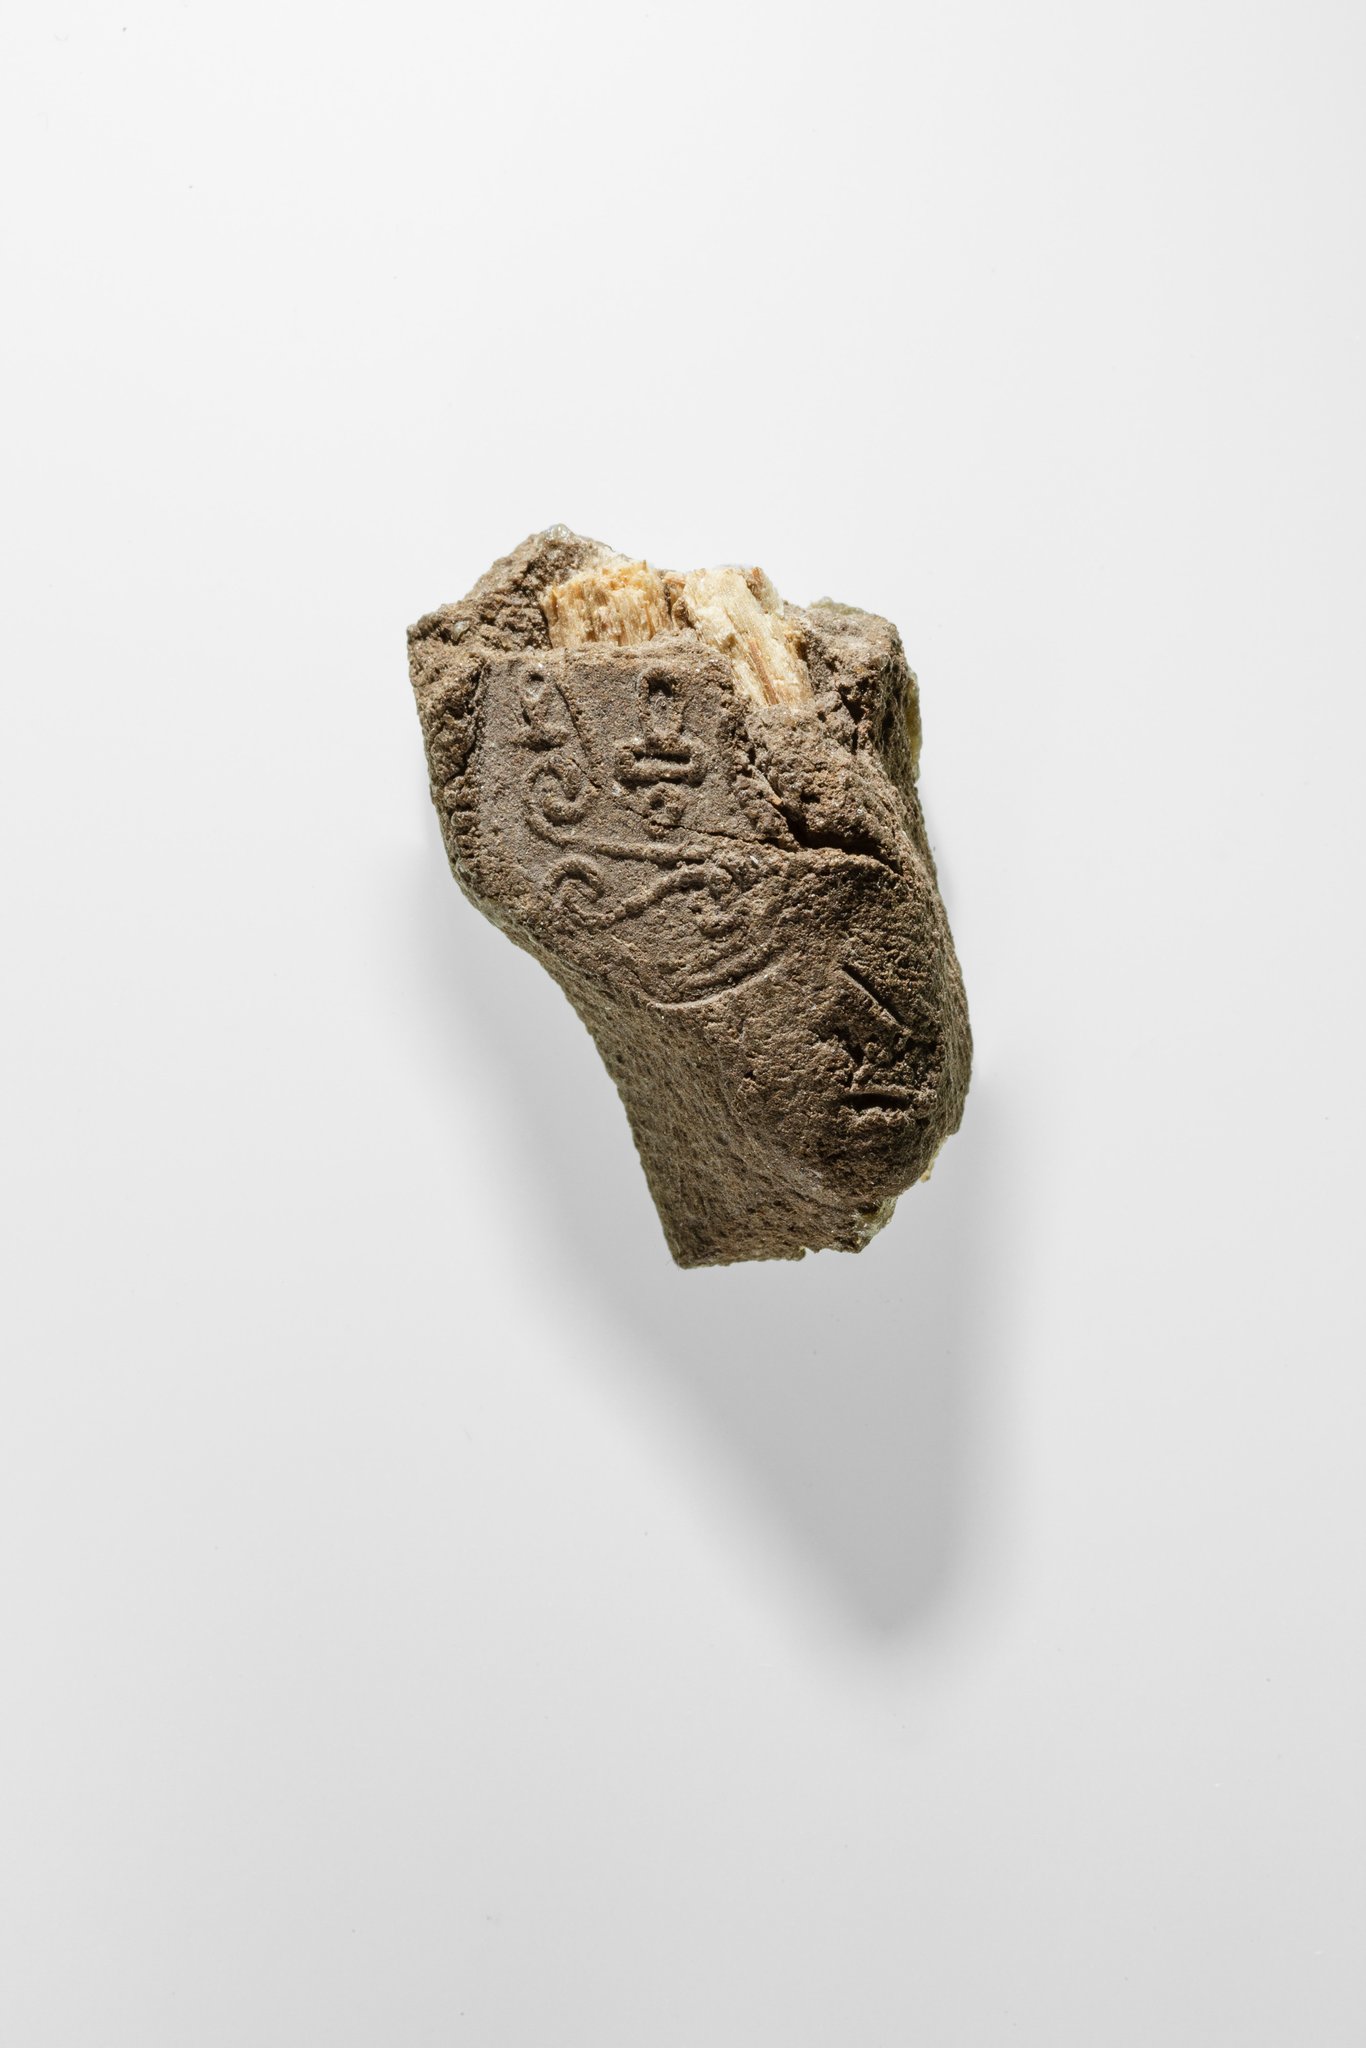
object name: sealing, letter, heqanakht, rahotep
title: Sealing, from letter 22.3.518 from Heqanakht to Rahotep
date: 1961-1917 BCE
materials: fiber, mud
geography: egypt